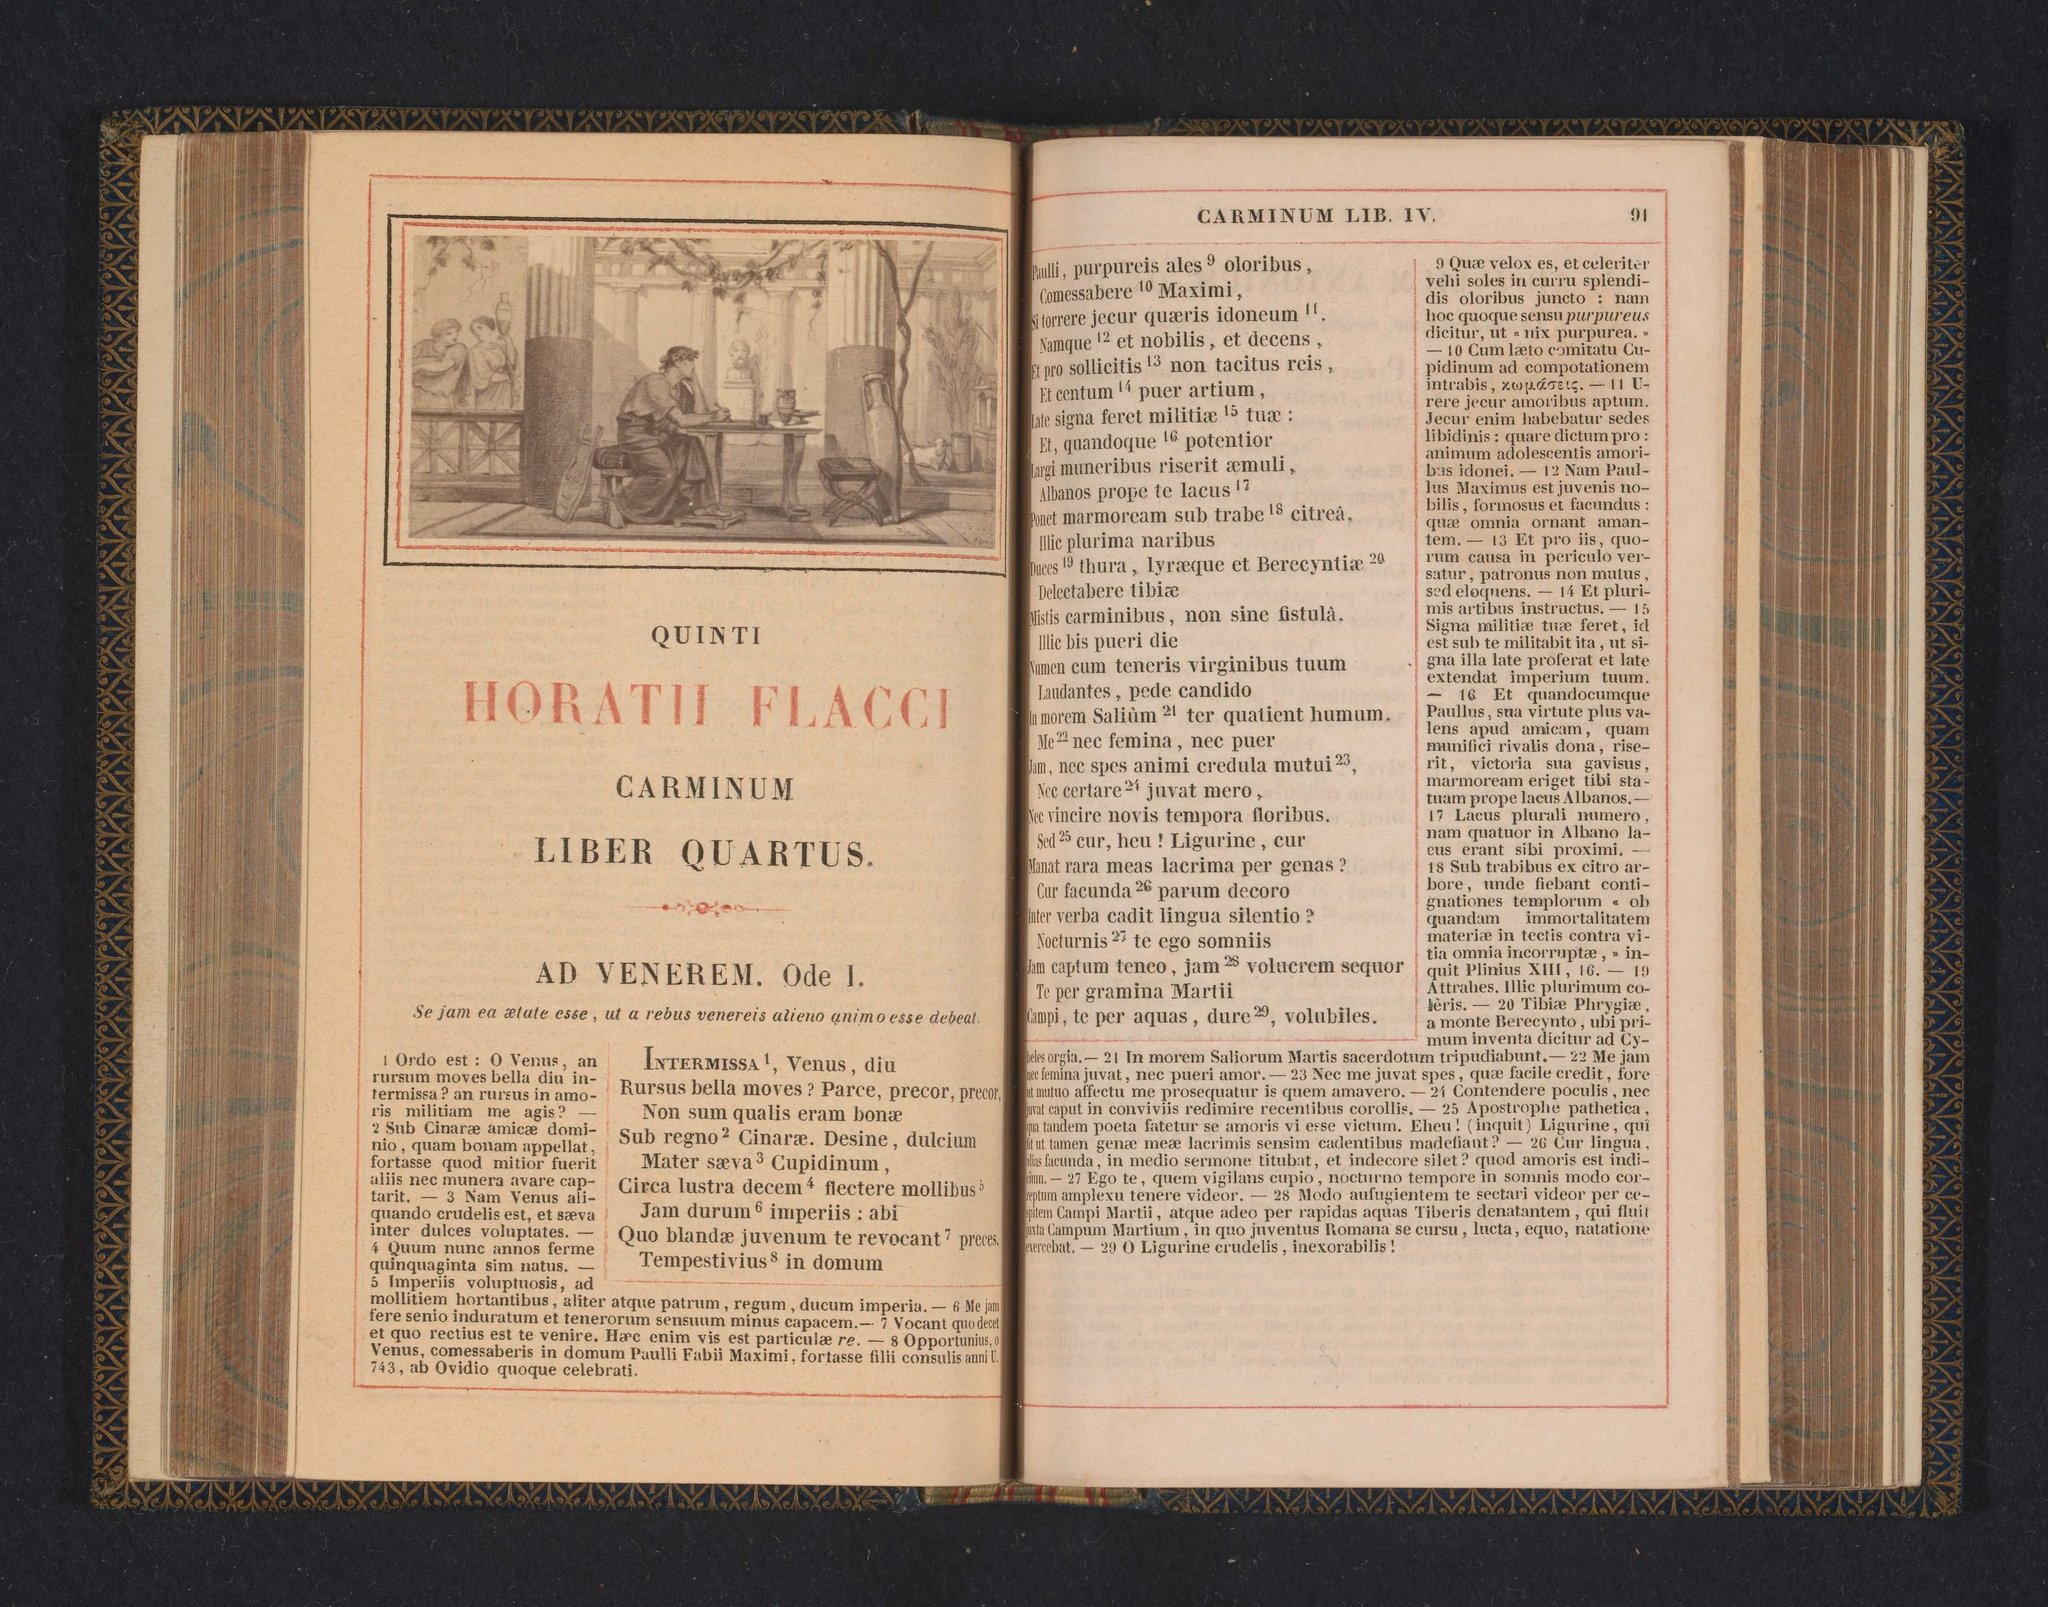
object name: reproduction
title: Fotoreproductie van een schilderij, voorstellende een schrijver aan een tafel in een interieur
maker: Anonymous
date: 1850-1855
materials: photographic support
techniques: albumen print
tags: writing-table, writing-desk, handwriting, writing as activity, interior ~ representation of a building